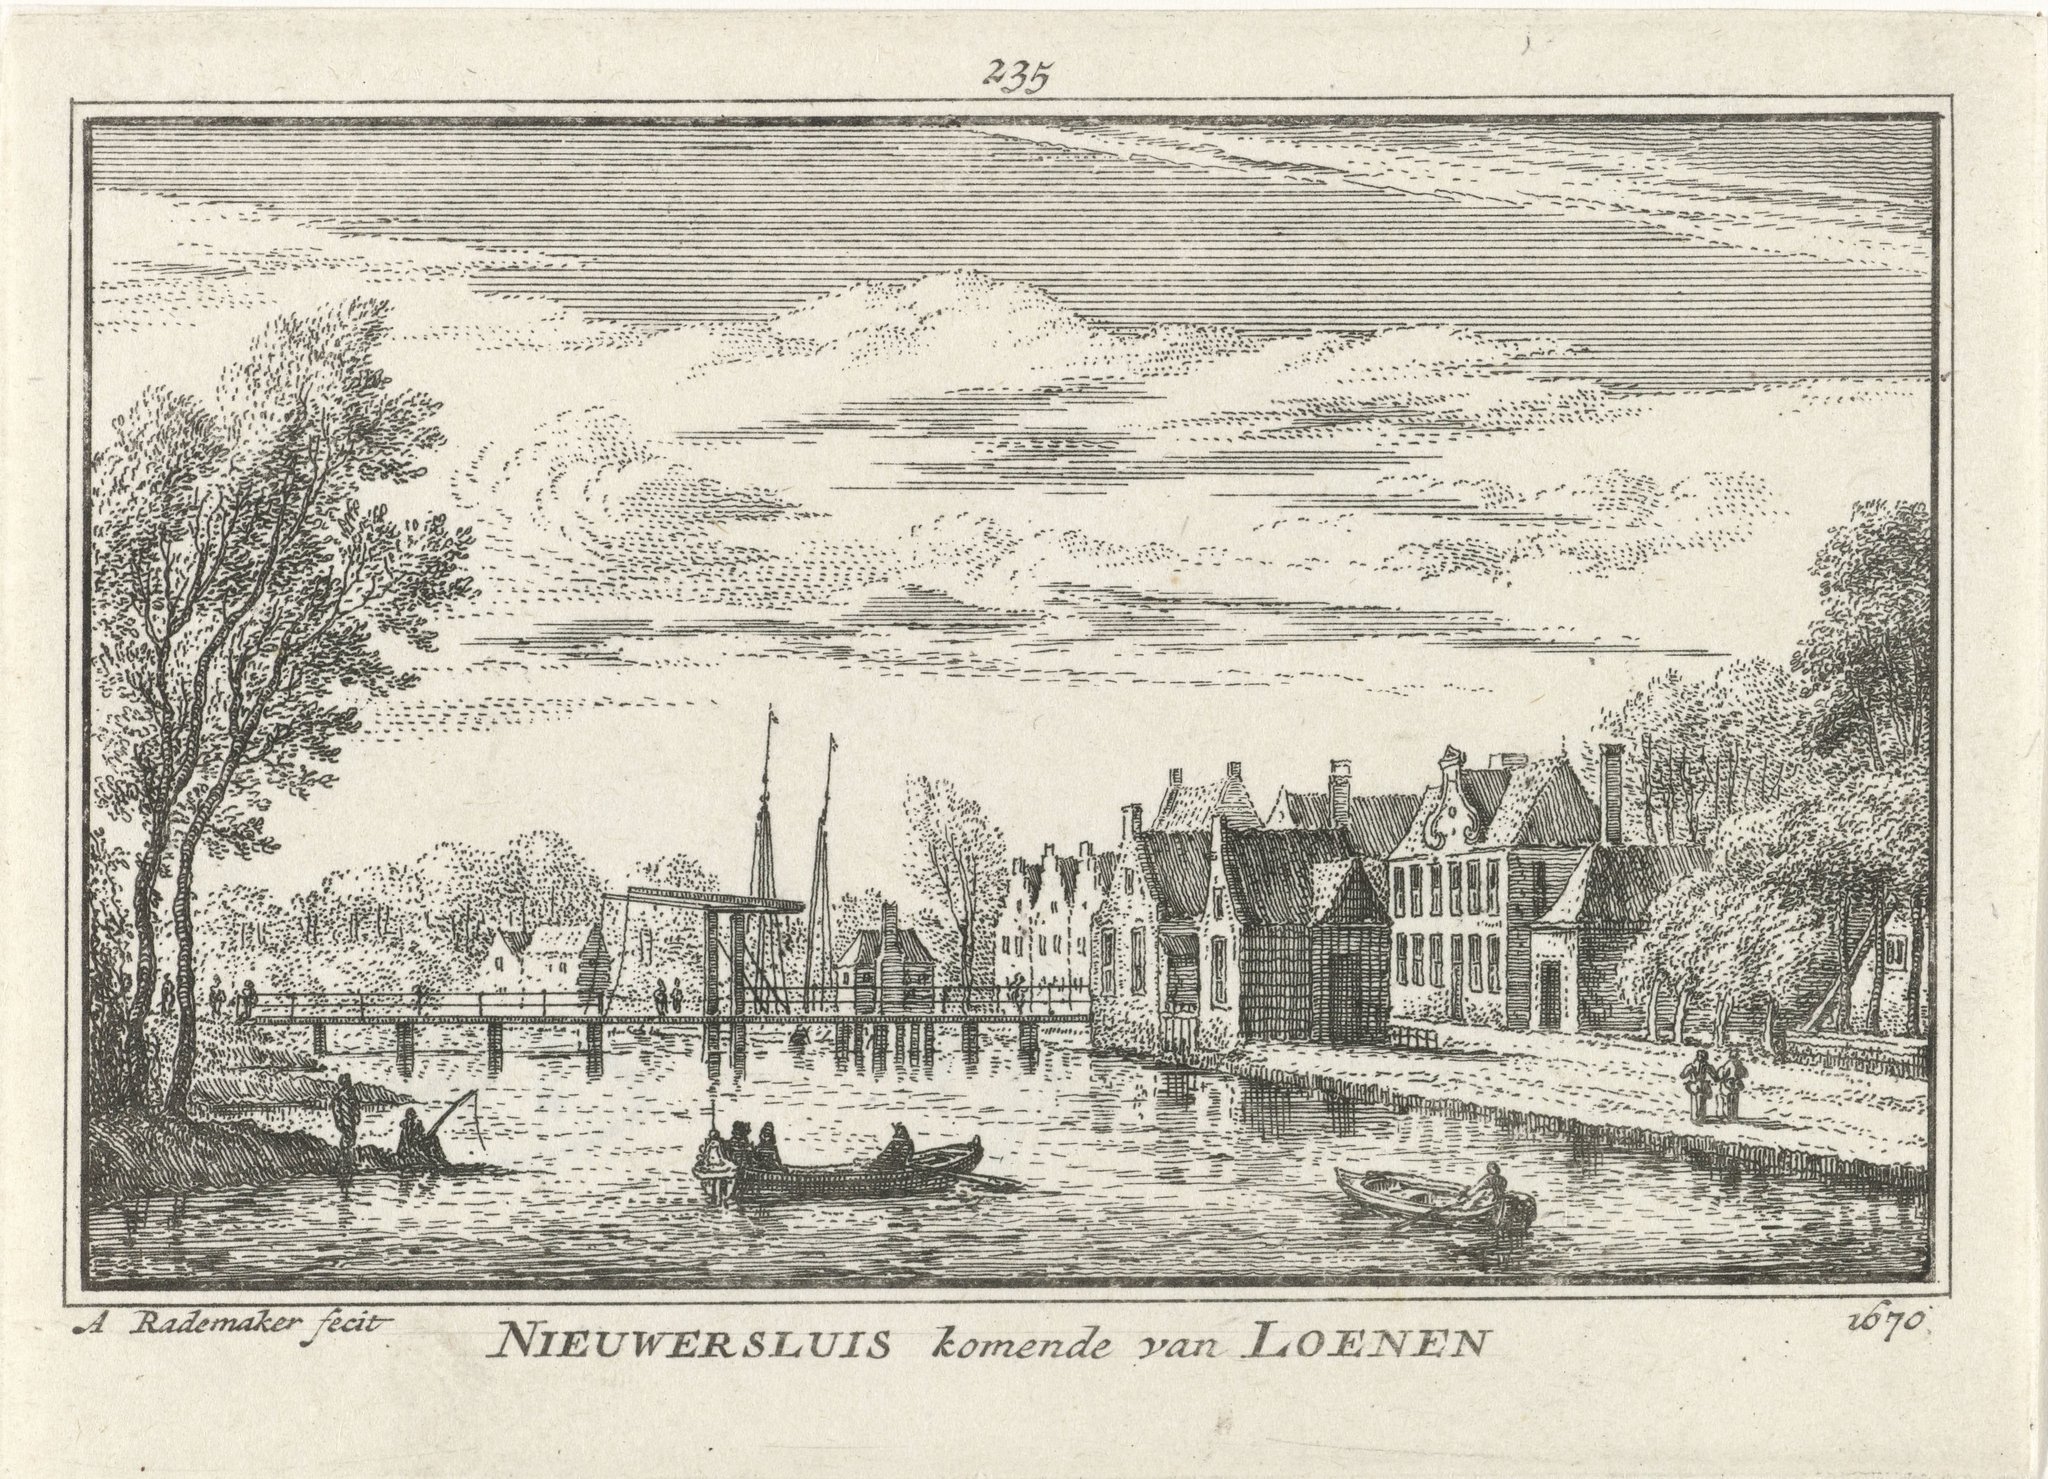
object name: print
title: Nieuwersluis komende van Loenen 1670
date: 1727-1733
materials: paper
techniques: etching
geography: amsterdam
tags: prospect of village, silhouette of village, rowing-boat, canoe, etc., bridge, vecht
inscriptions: collector's mark: Lugt 2228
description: Illustratie uit: Abraham Rademaker, Matthaeus Brouërius van Niedek, Isaac Le Long, Kabinet van Nederlandsche en Kleefsche outheden en (...) voorname stads- en landgebouwen, Willem Barents en Antoni Schoonenburg: Amsterdam, 1727-1733, ill. nr. 235.